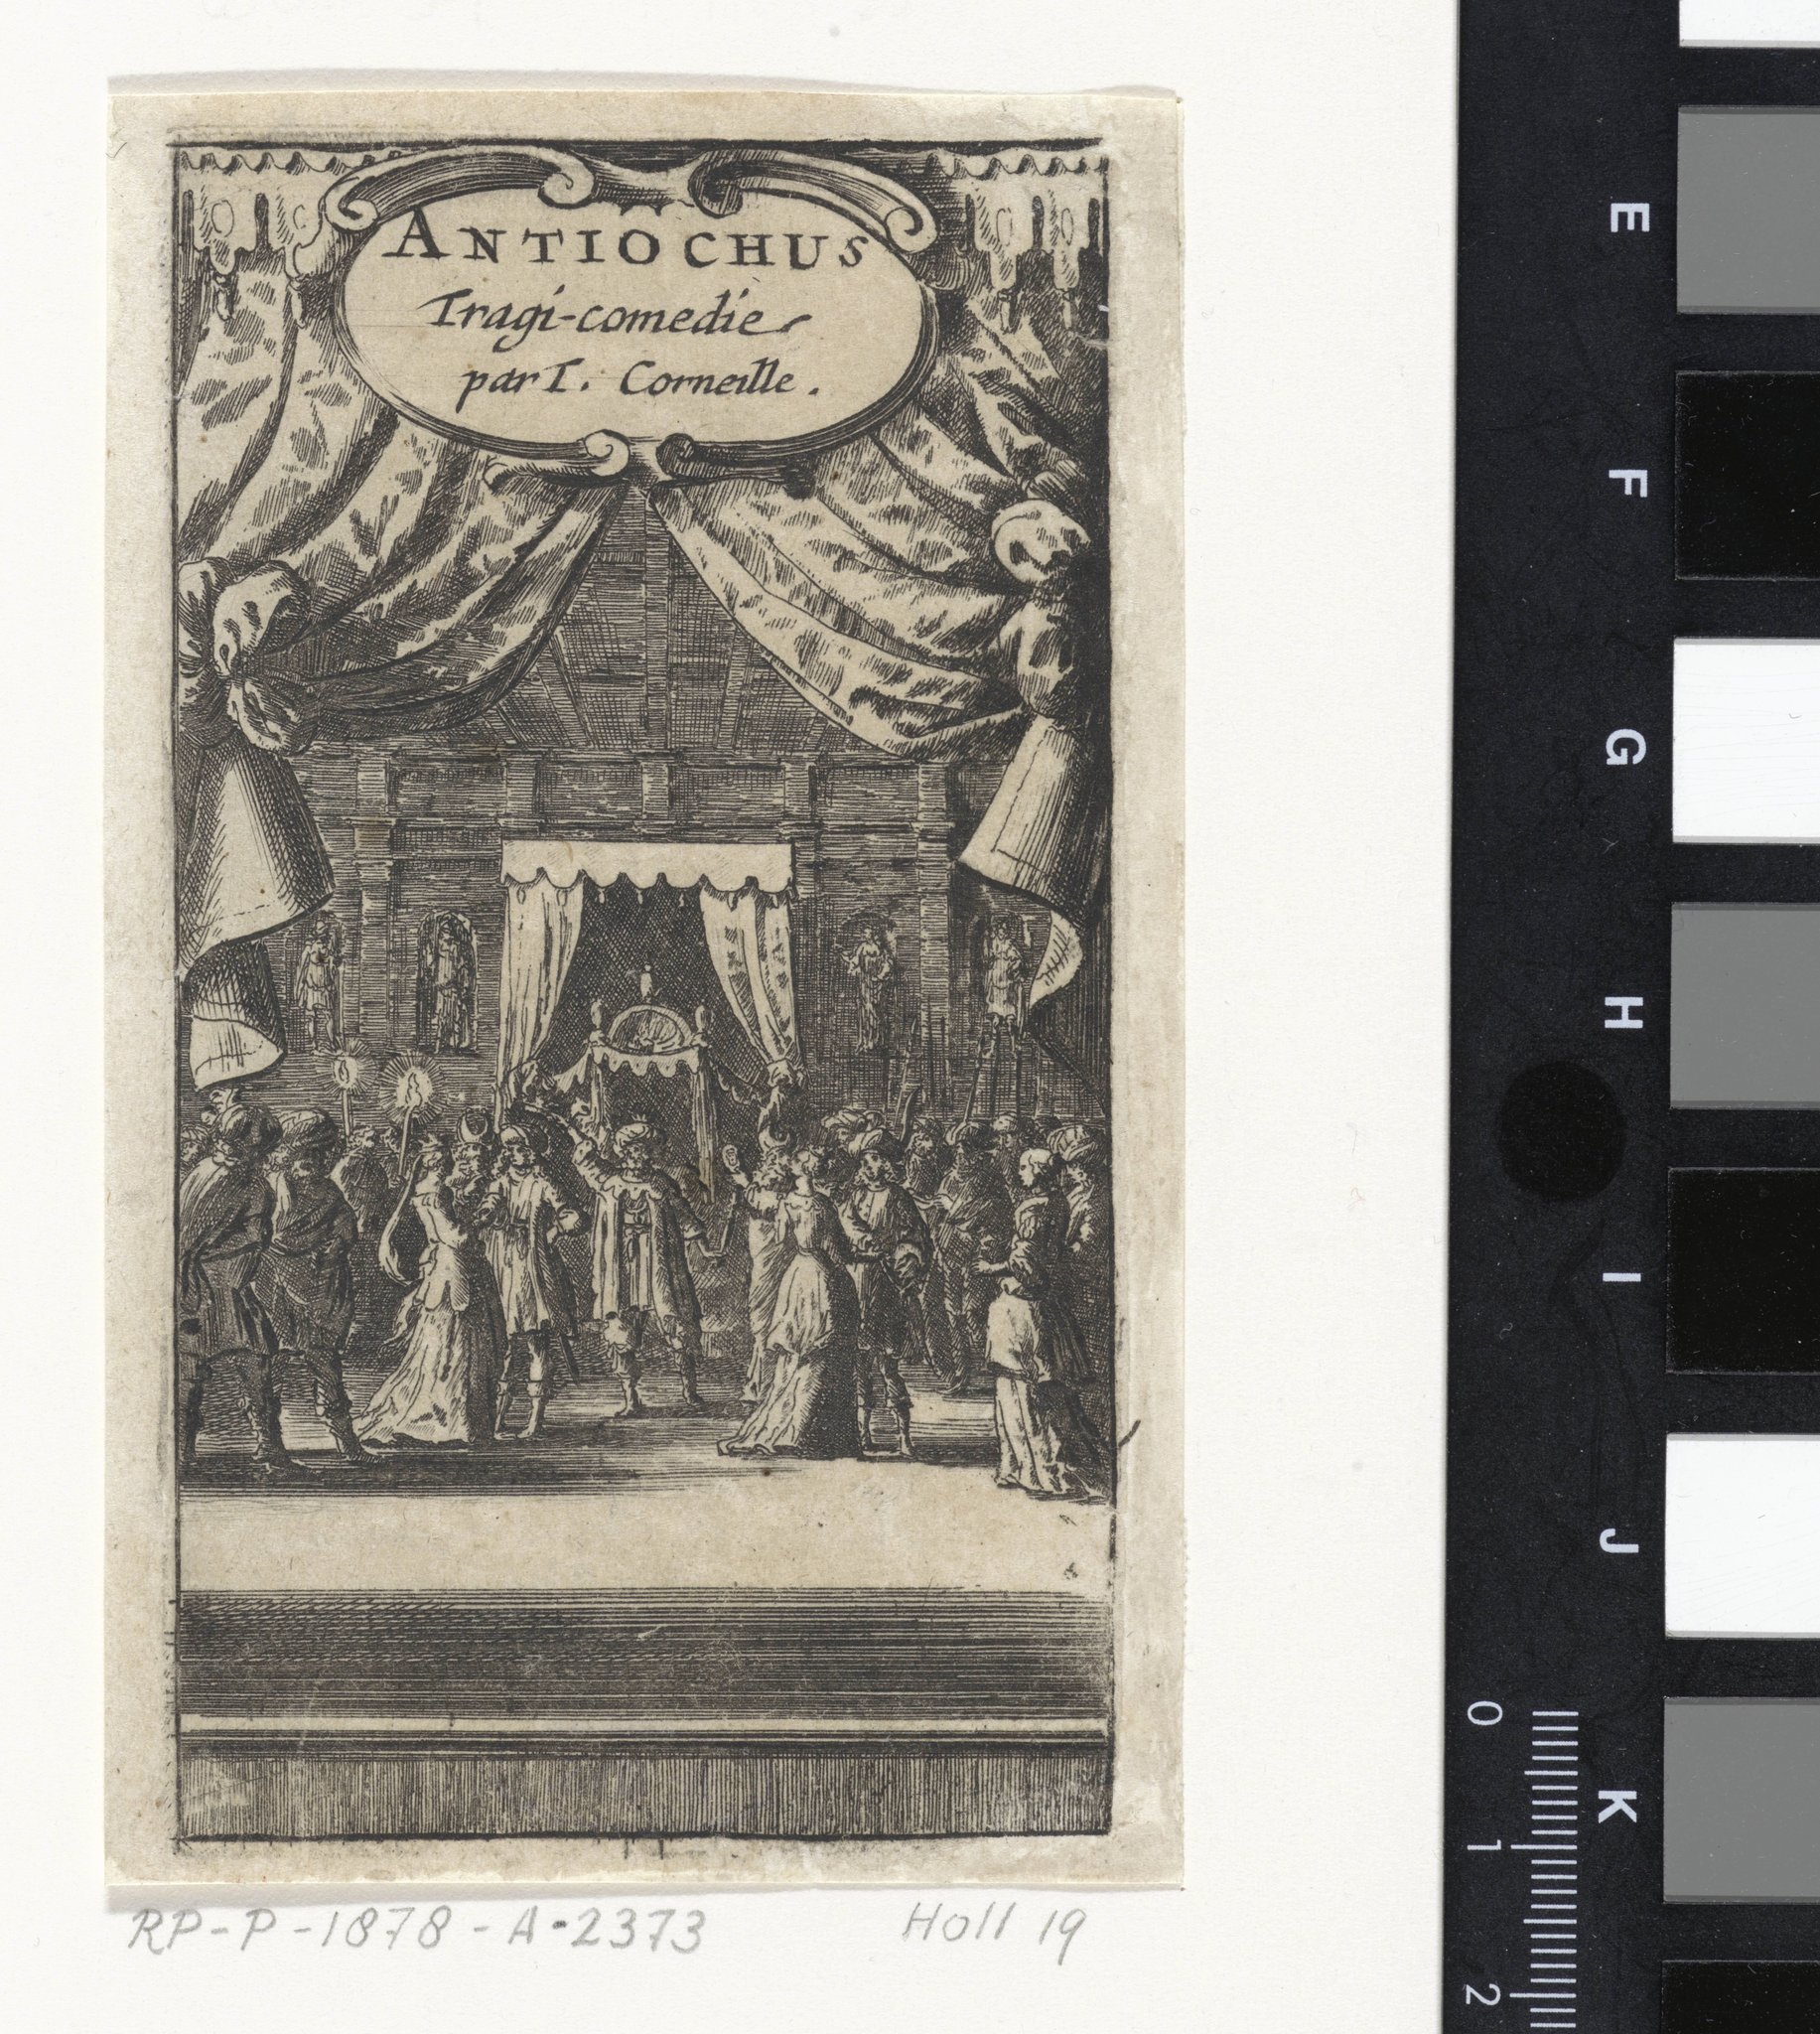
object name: print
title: Seleucus kroont Antiochus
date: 1666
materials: paper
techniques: etching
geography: netherlands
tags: theatre, theatrical performance, antiochus i (soter) and stratonice: by taking antiochus' pulse when stratonice enters the room, the physician discovers that the love for his stepmother is the cause of his illness (king seleucus subsequently hands his kingdom and his wife over to his son), title-page, throne-room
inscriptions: collector's mark: Lugt 2228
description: Seleucus kroont zijn zoon Antiochus in de troonzaal tot koning, nadat Antiochus verliefd is geworden op zijn stiefmoeder Stratonica. Stratonica staat naast hem. Verschillende hovelingen kijken toe. Boven theatergordijnen en een cartouche met de titel.